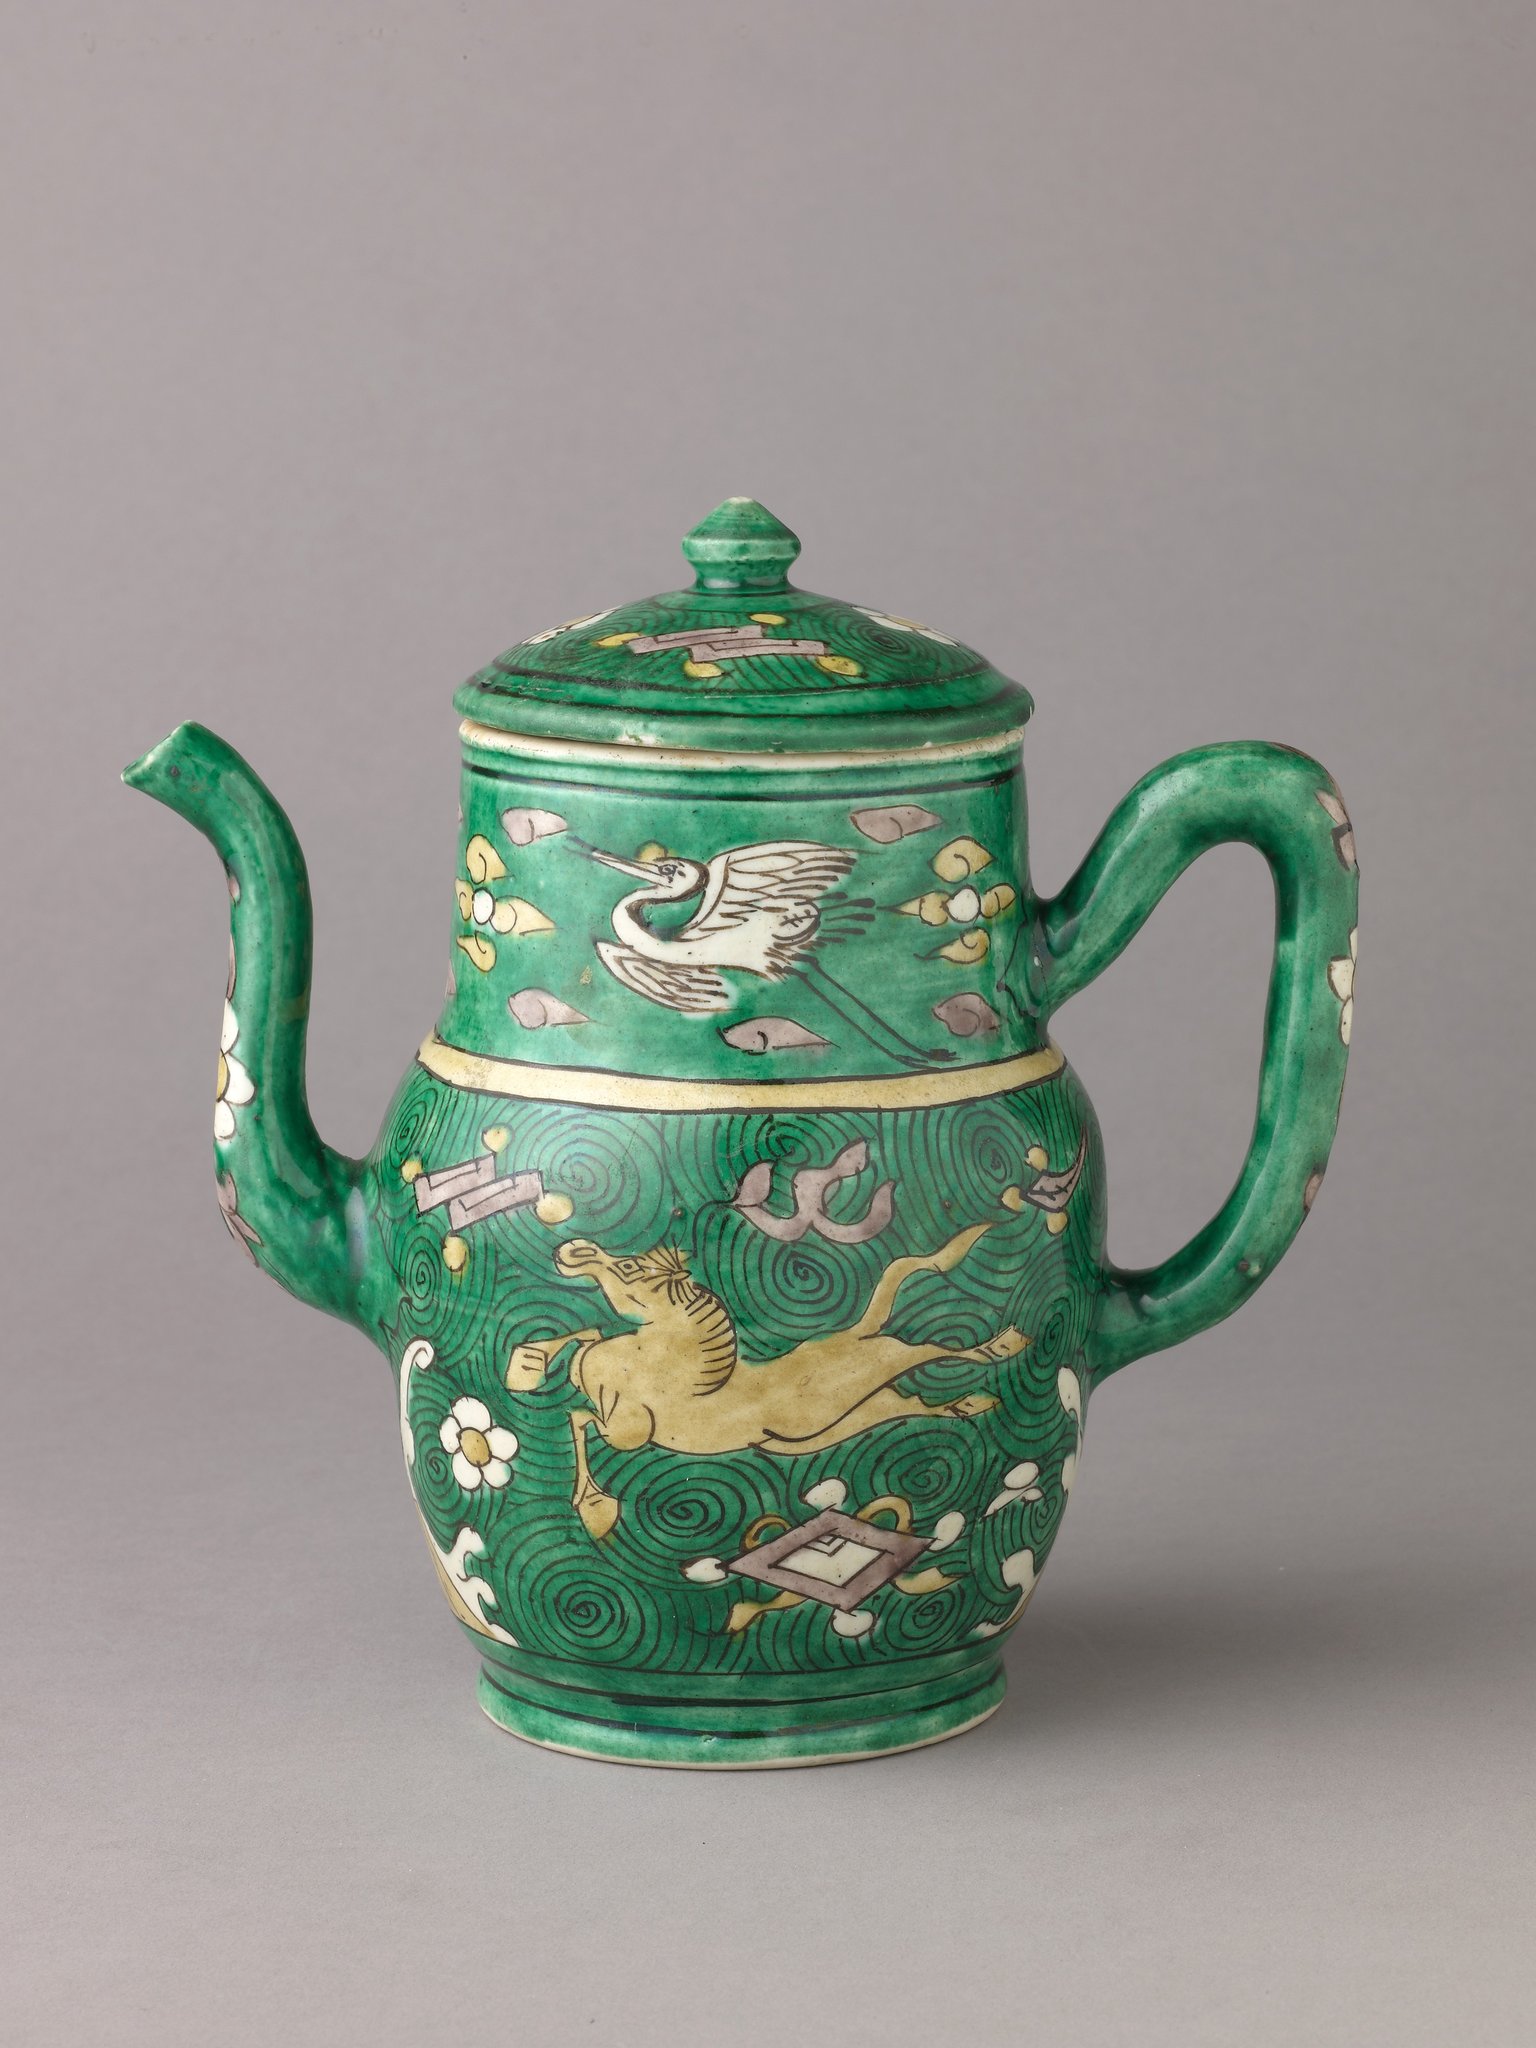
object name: ewer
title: Covered ewer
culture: chinese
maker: chinese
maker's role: artist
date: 1644-1683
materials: biscuit, enamel, porcelain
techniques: painting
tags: cranes,horses